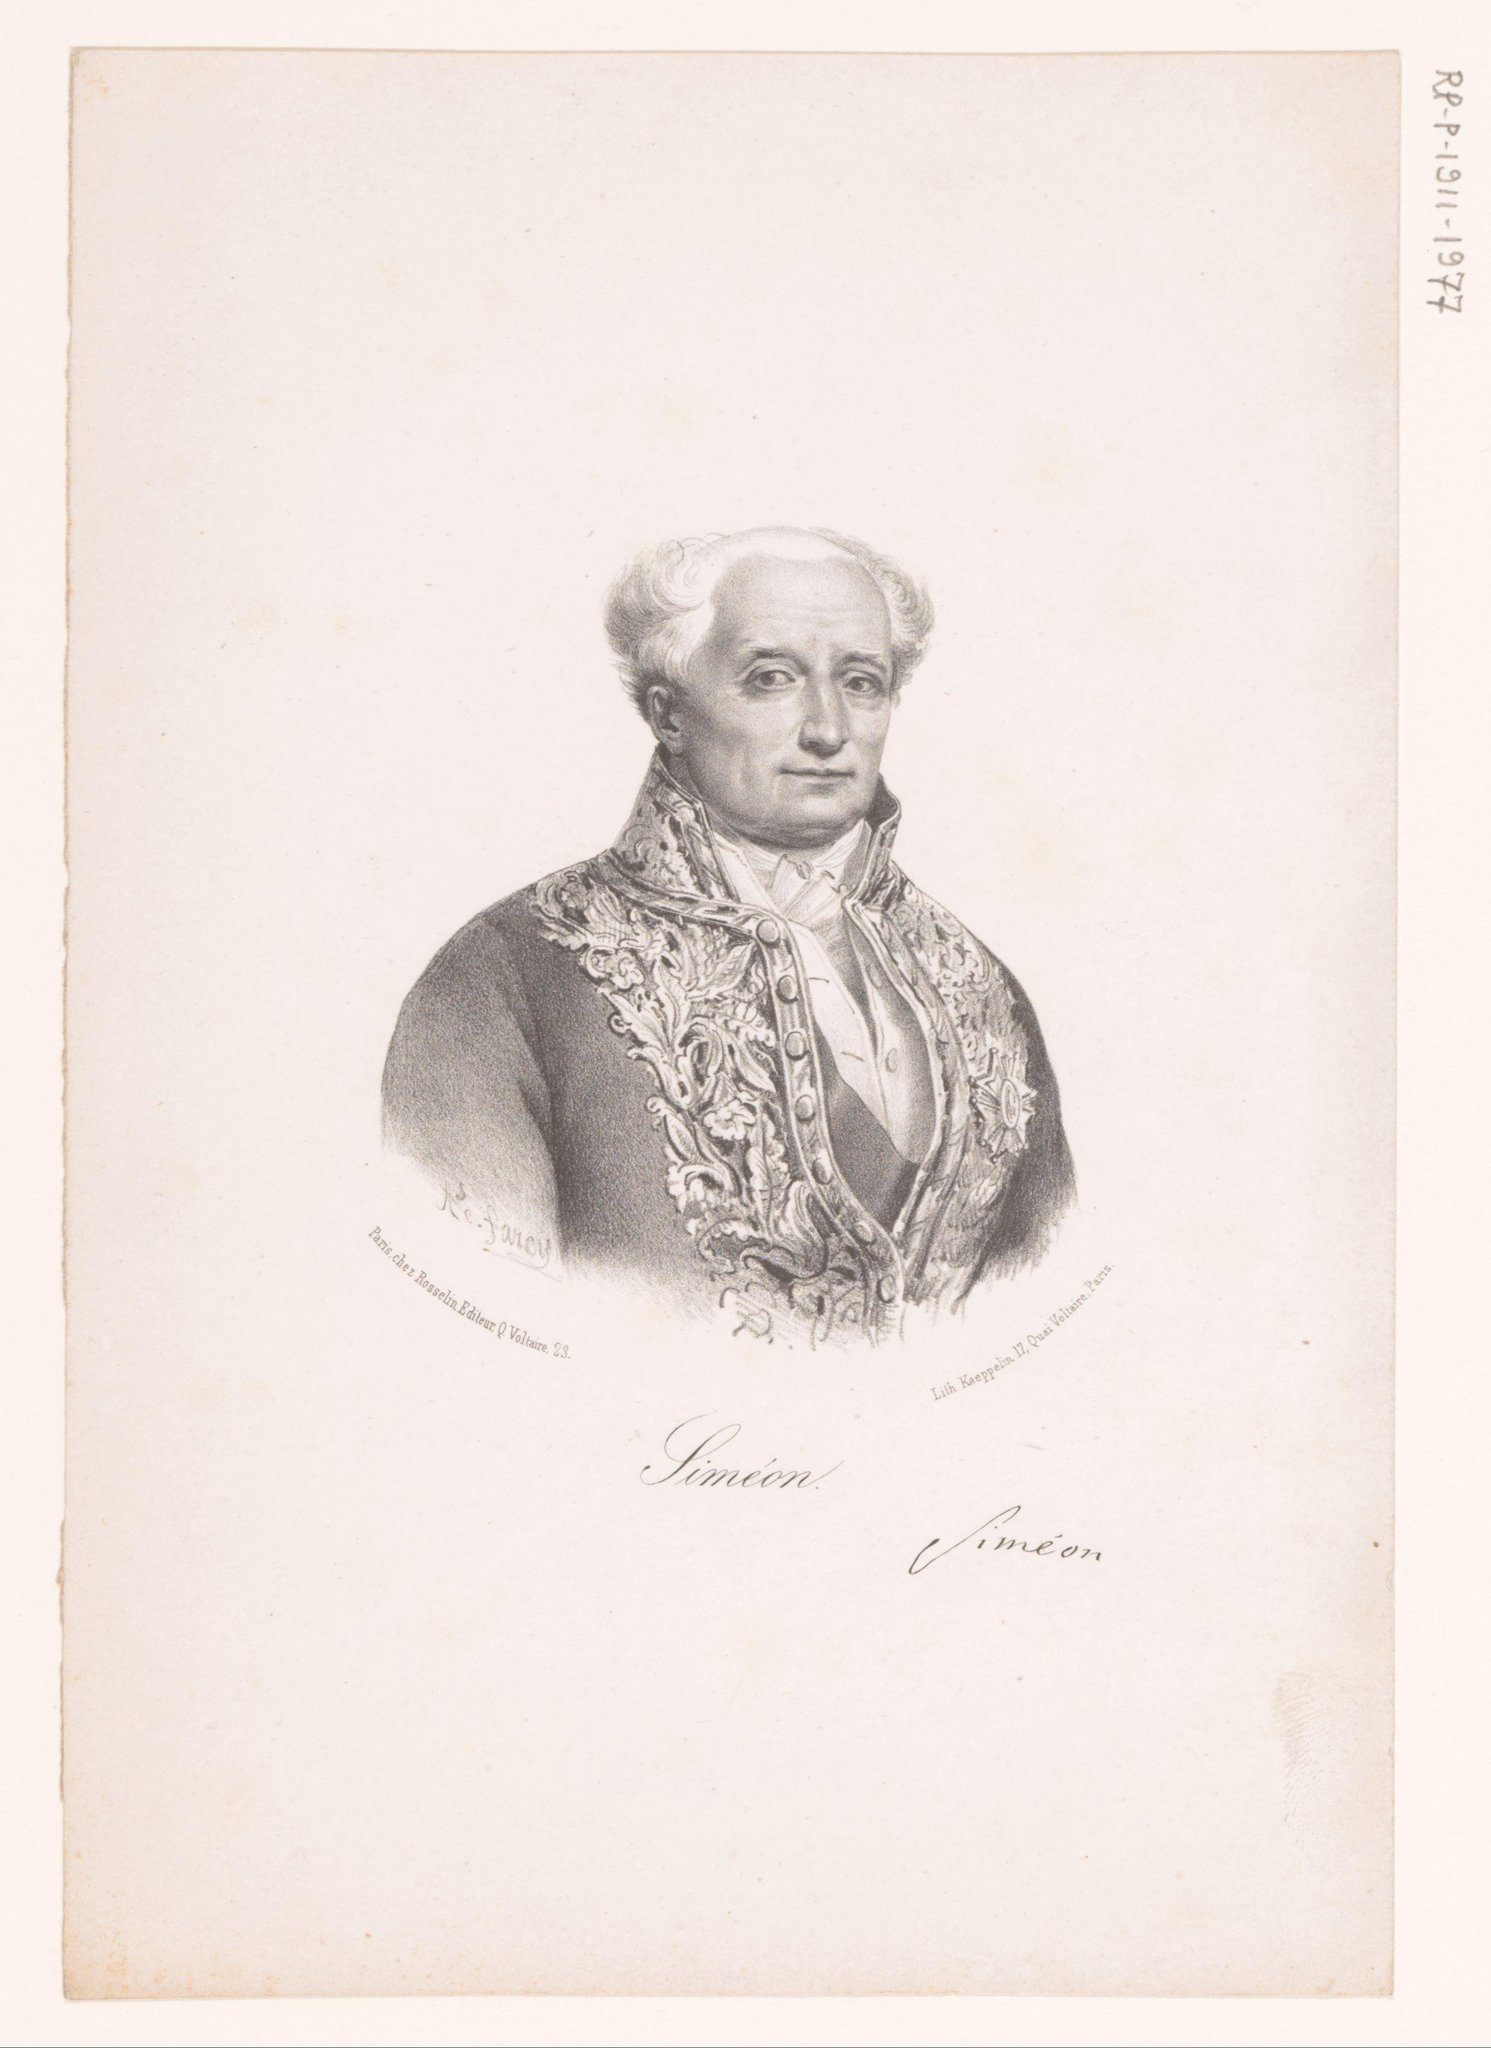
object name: print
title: Portret van Joseph Jérôme Siméon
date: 1853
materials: paper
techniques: lithograph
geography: paris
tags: paris, politician, historical persons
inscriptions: collector's mark: Lugt 2228a